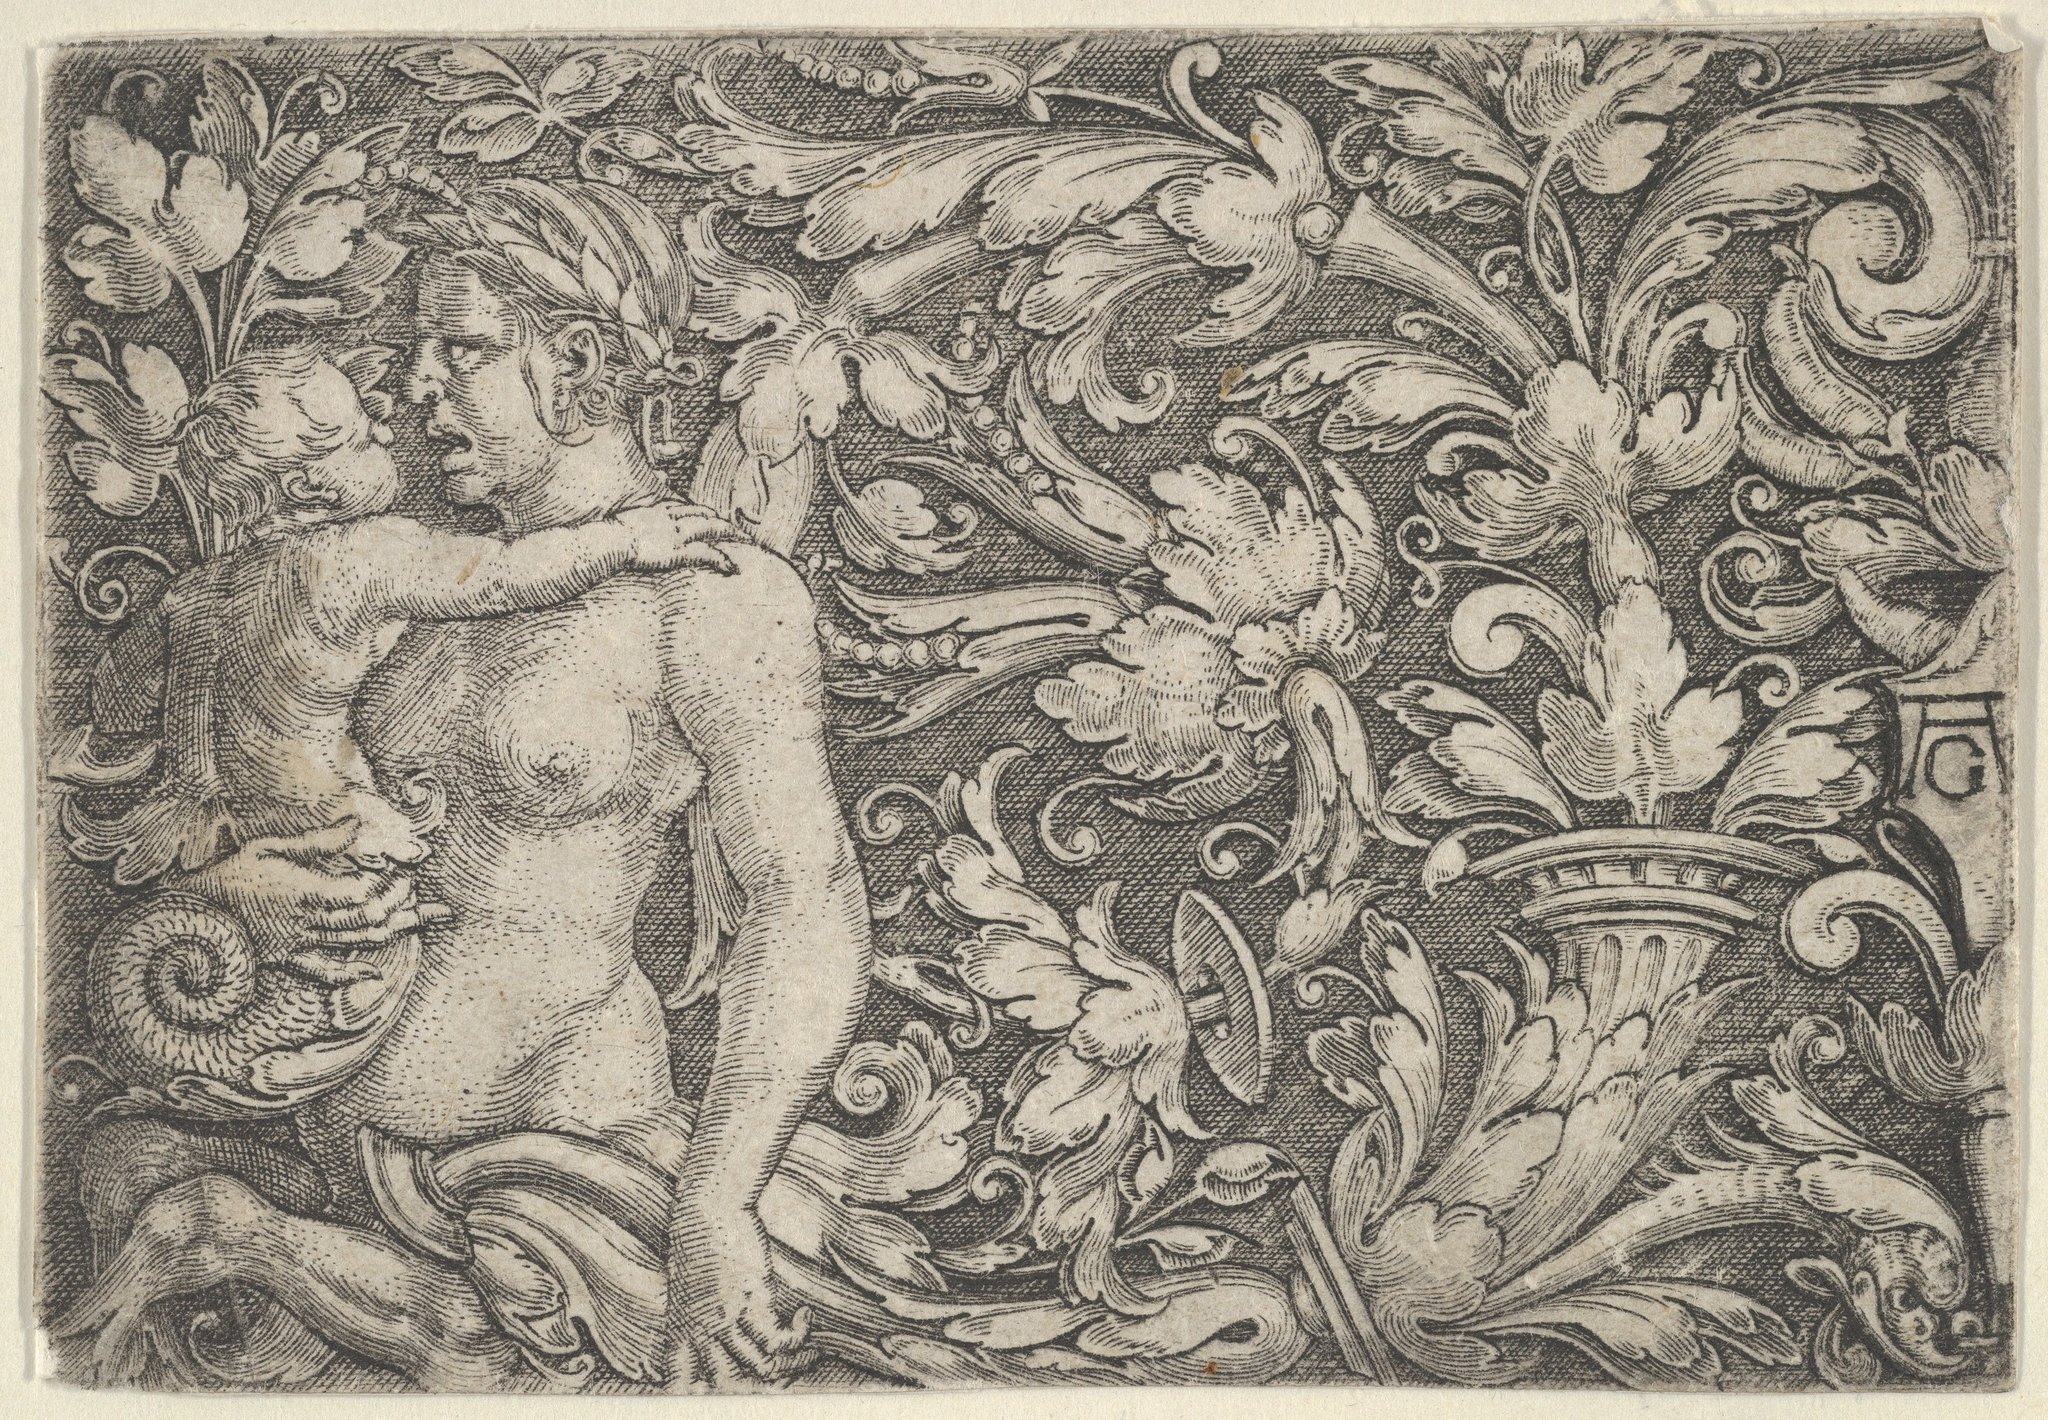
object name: print ornament architecture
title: Horizontal Panel with Triton and Child Surrounded by Foliage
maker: heinrich aldegrever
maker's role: artist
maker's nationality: german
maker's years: 1502-1561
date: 1525-1561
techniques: engraving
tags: triton